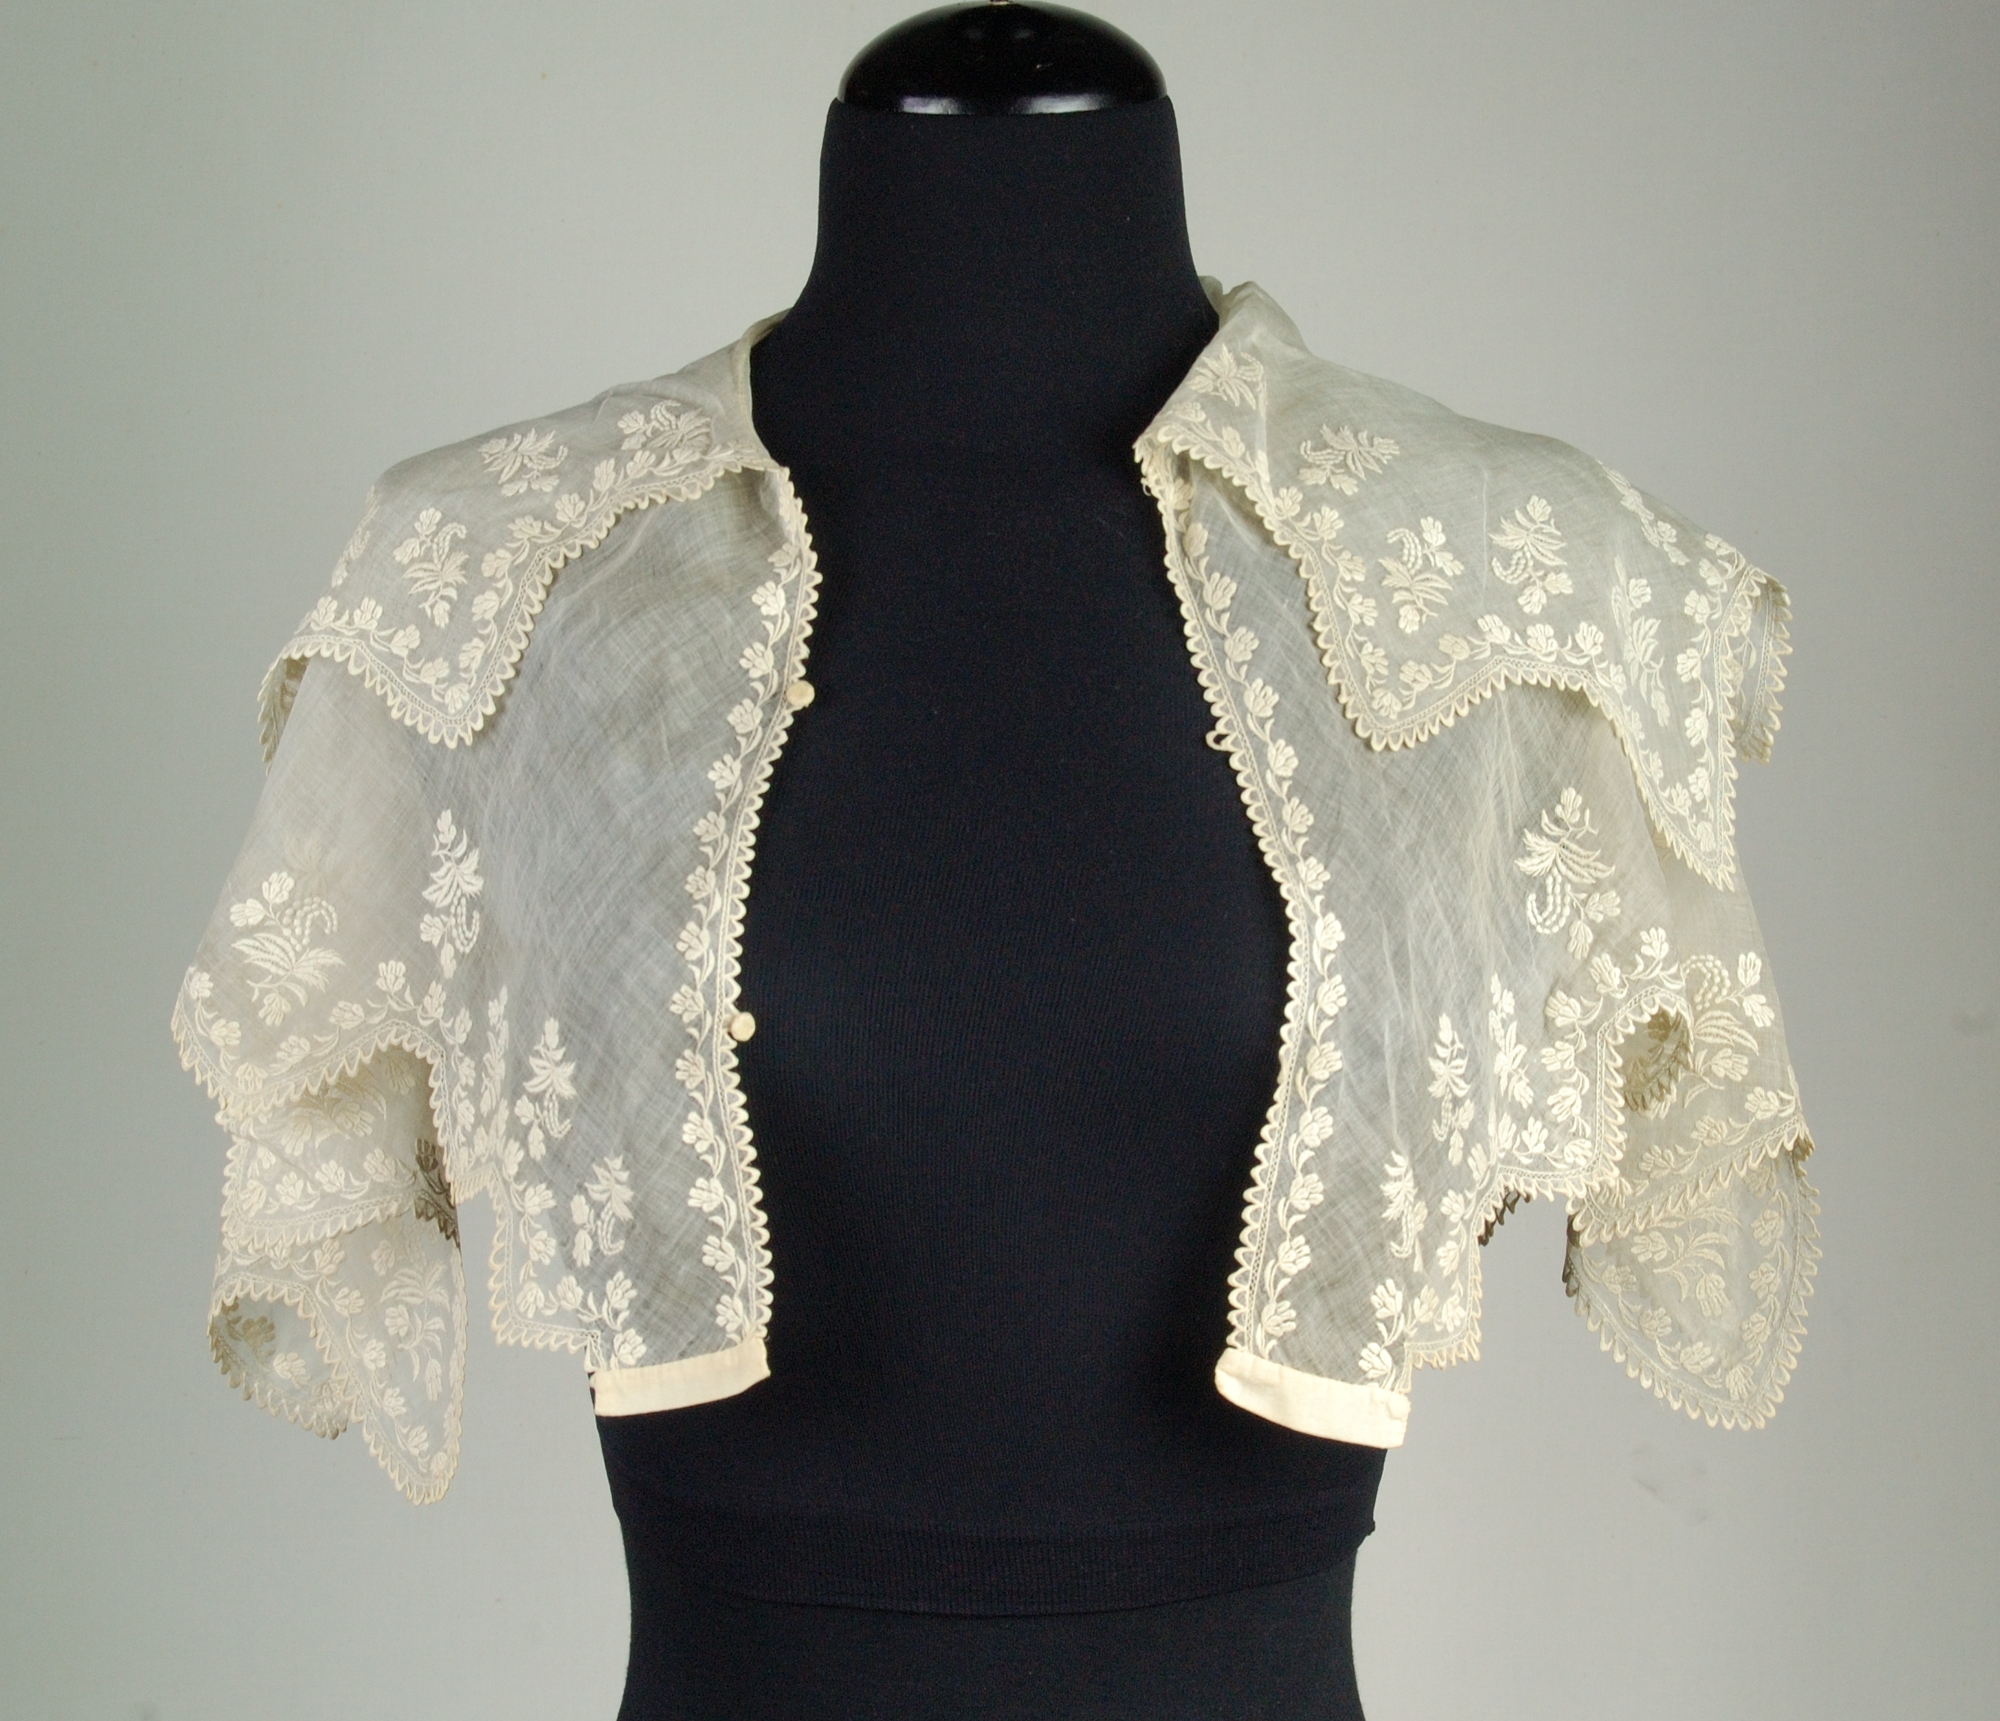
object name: pelerine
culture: american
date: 1830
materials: cotton